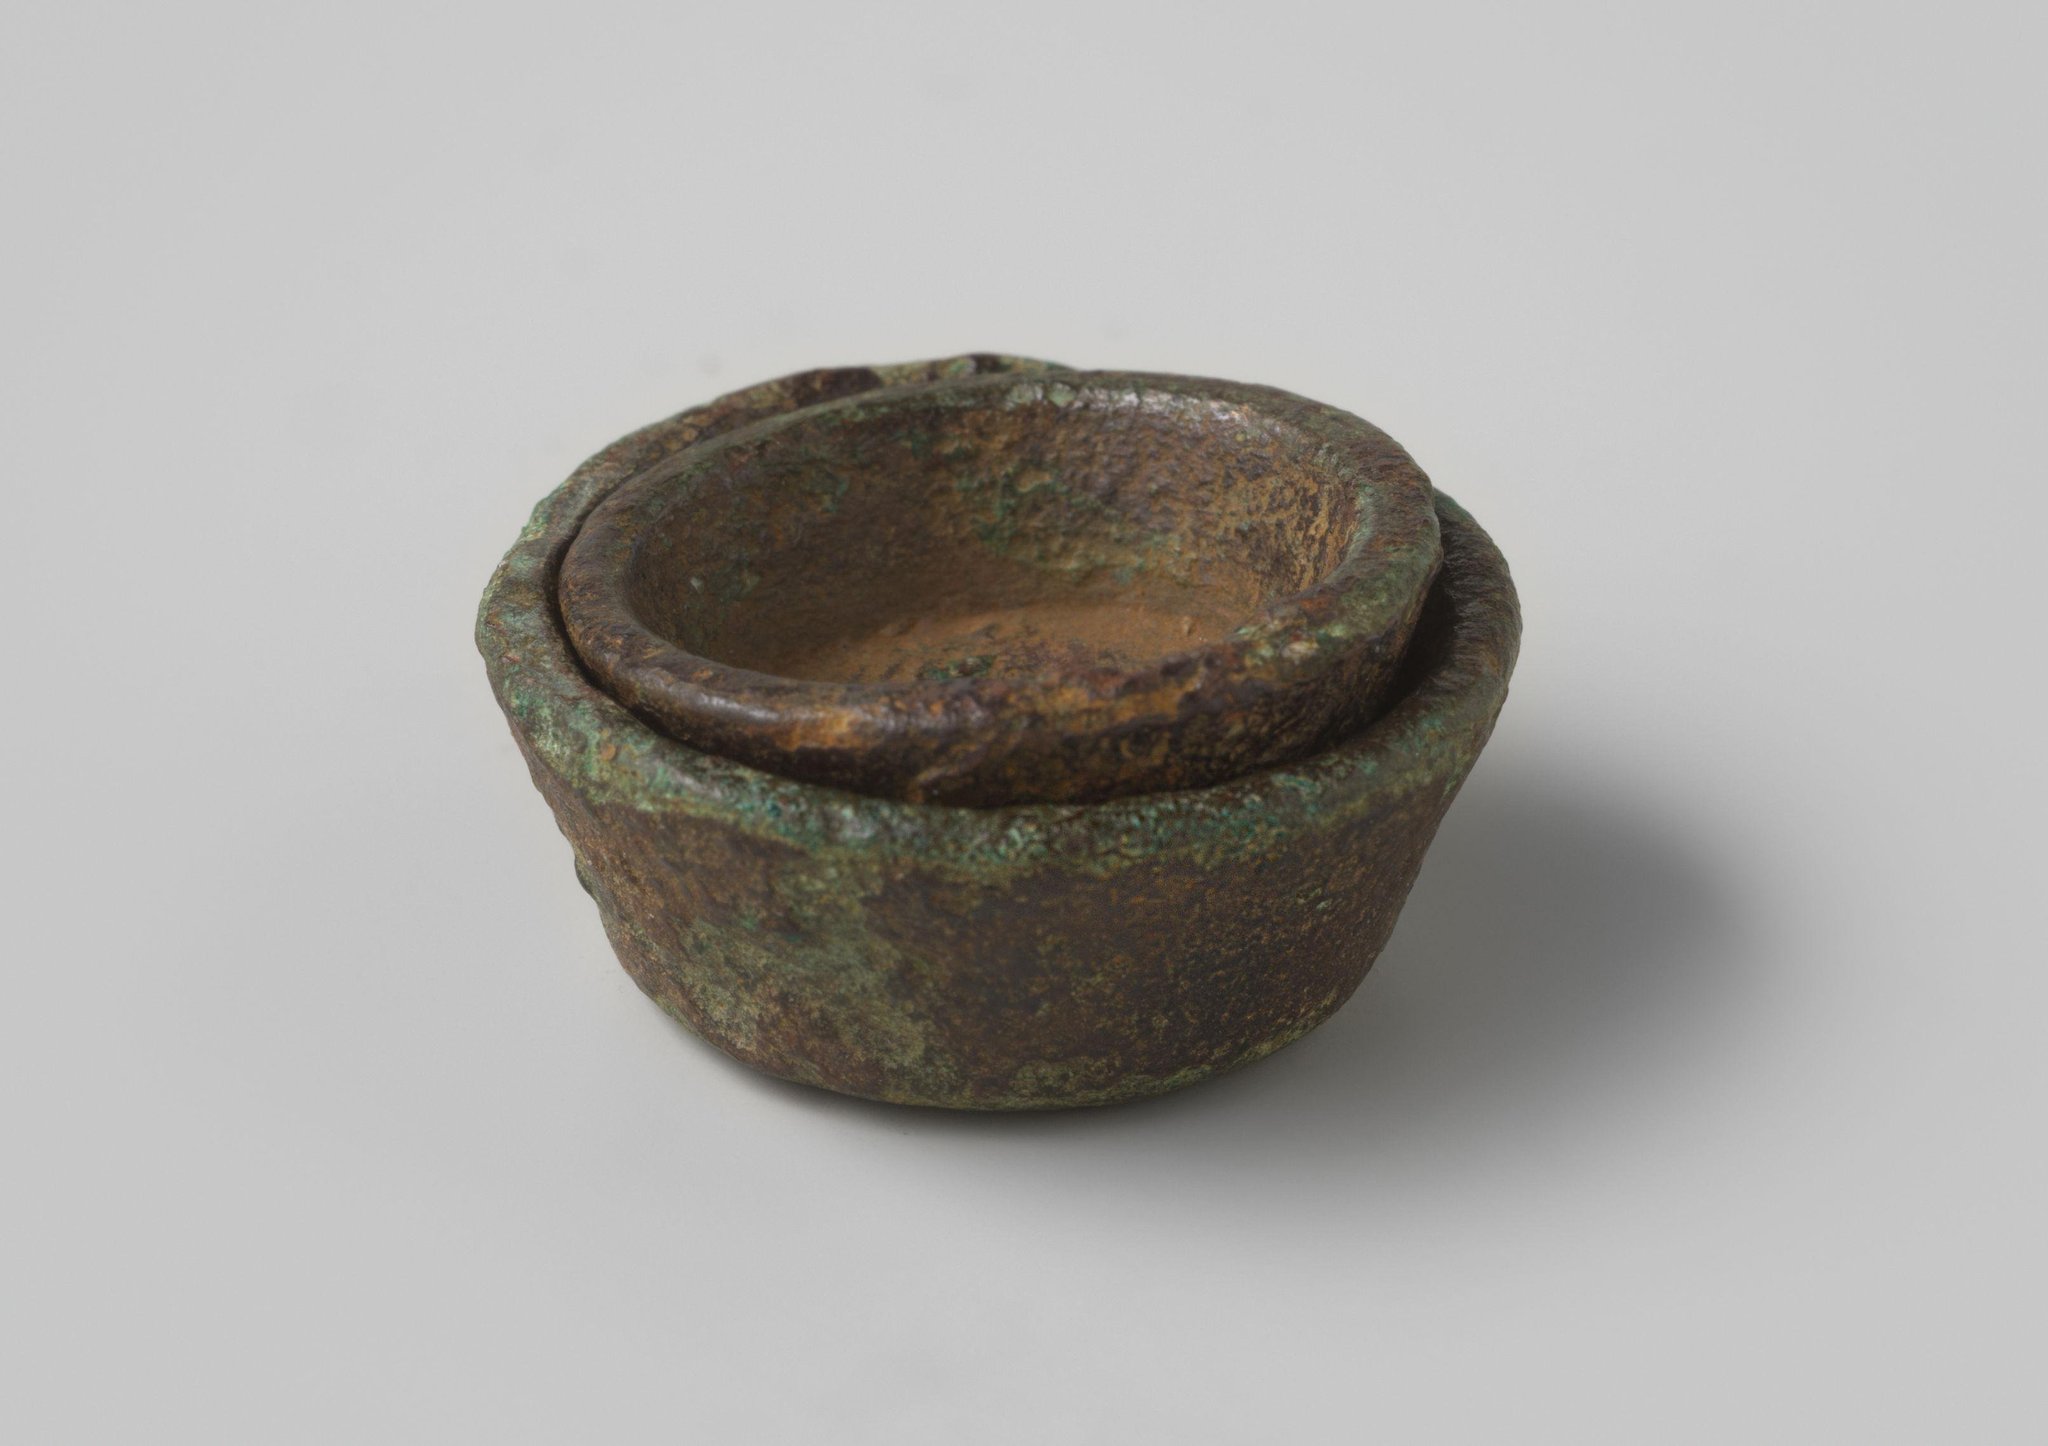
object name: sluitgewicht, pijlgewicht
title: Gewichten van sluitgewicht uit het wrak van de Oost-Indiëvaarder Hollandia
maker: Anonymous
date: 1700-1743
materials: copper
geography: netherlands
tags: verenigde oostindische compagnie, hollandia (schip), annet